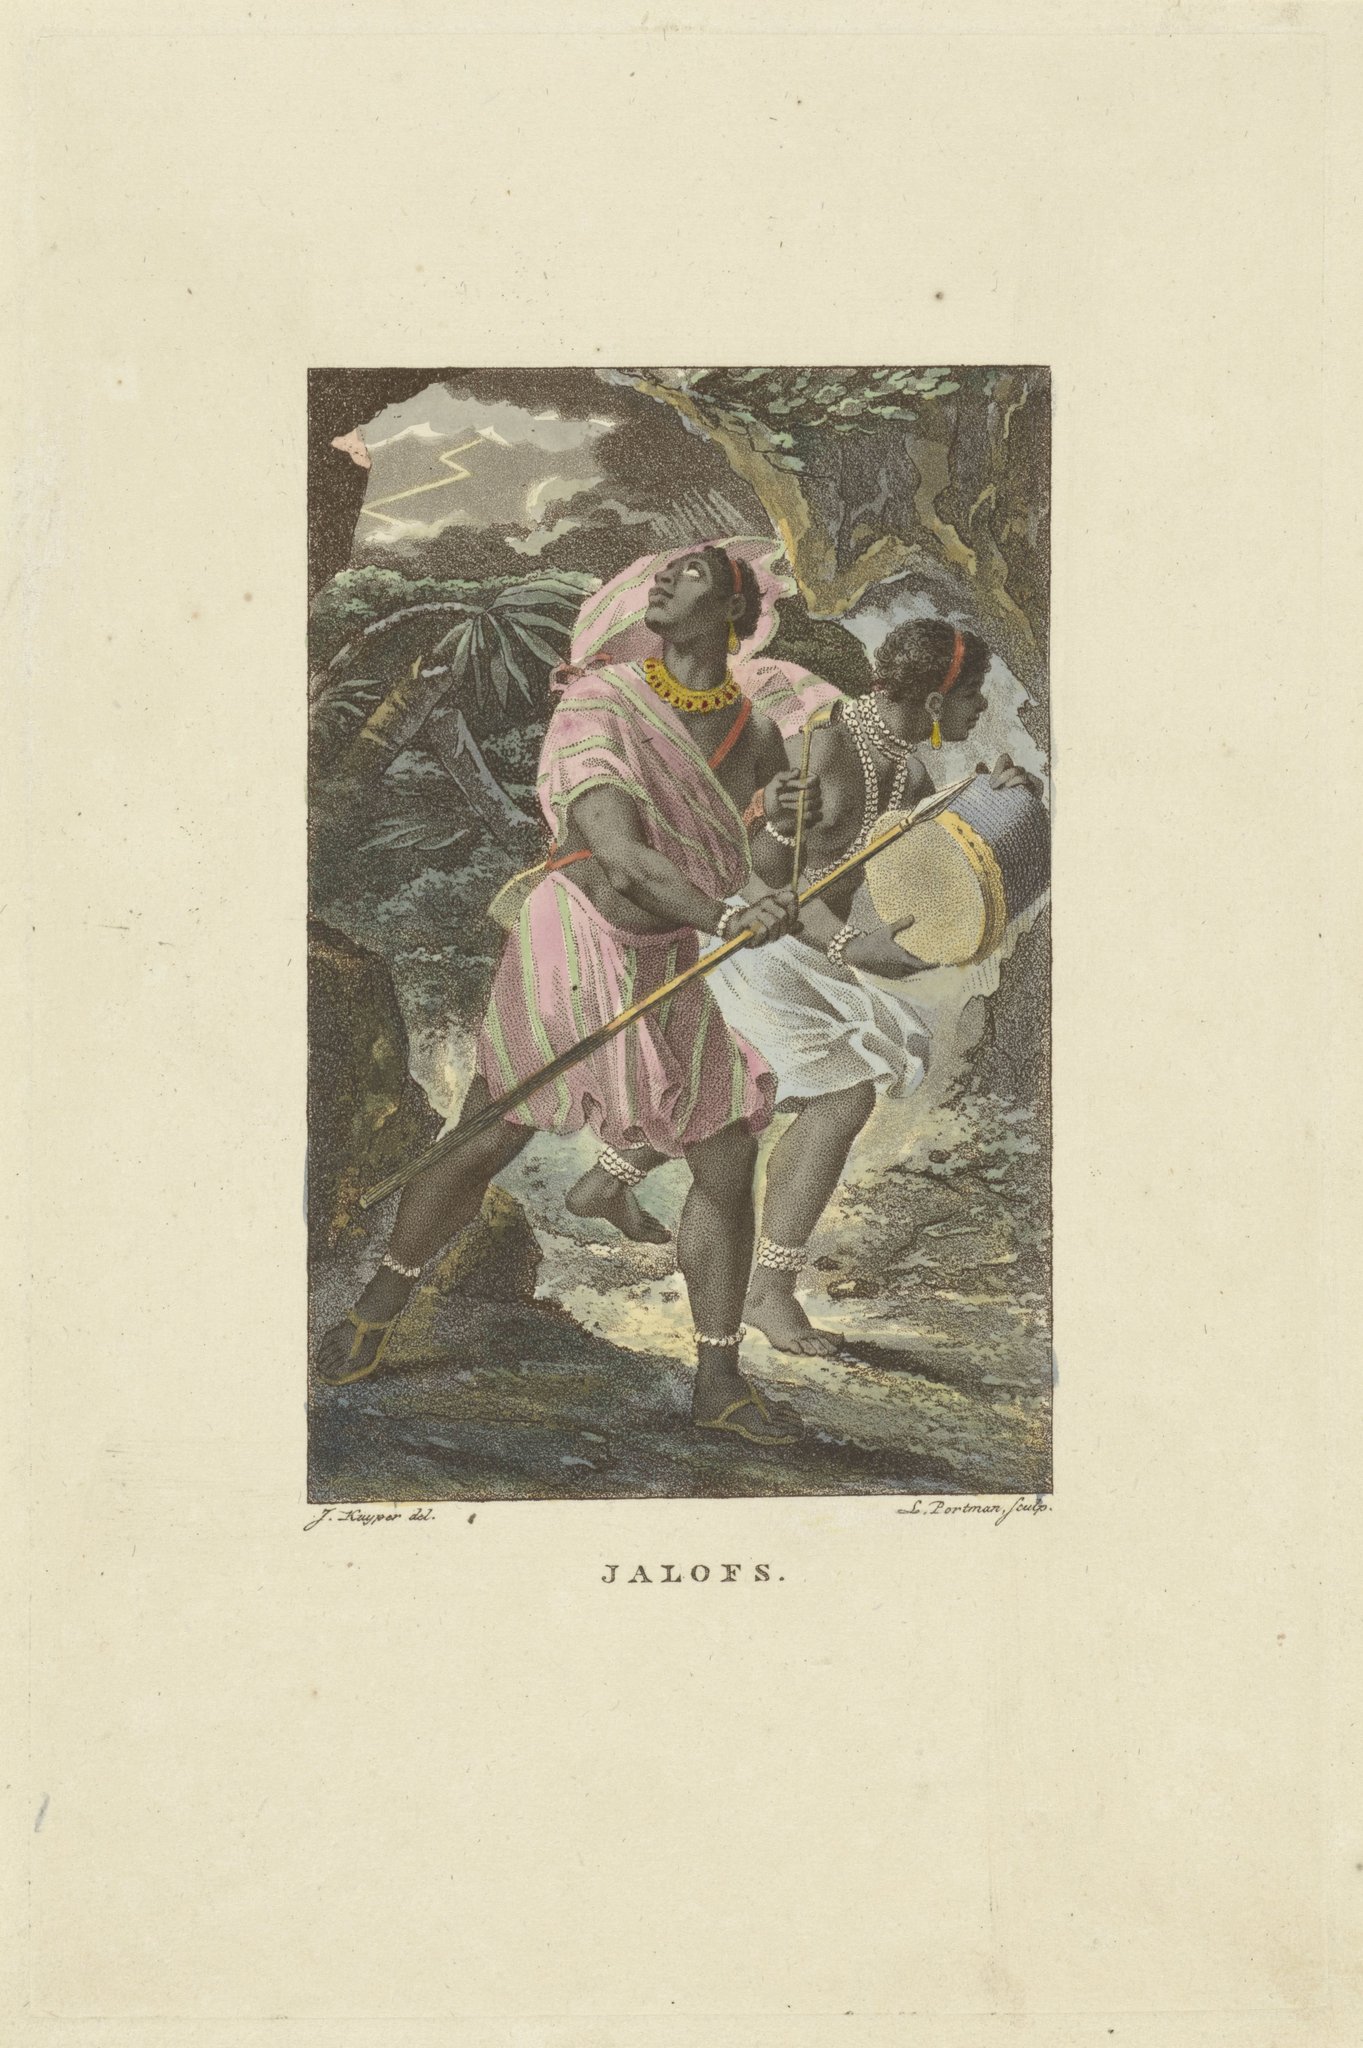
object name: print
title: Bewoners van westelijk Afrika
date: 1807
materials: paper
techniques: etching, hand coloring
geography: amsterdam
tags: ritual music and dancing ~ non-christian religions, human races; peoples; nationalities (+ costume), lightning, flash of lightning, thunderbolt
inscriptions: collector's mark: Lugt 2228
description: Een man en vrouw zijn op weg naar anderen om een krijgsdans uit te voeren. De vrouw heeft een oorlogstrommel in de hand en de man zijn speer. Ze dragen traditionele kleding. Op de achtergrond is hevig onweer gaande.